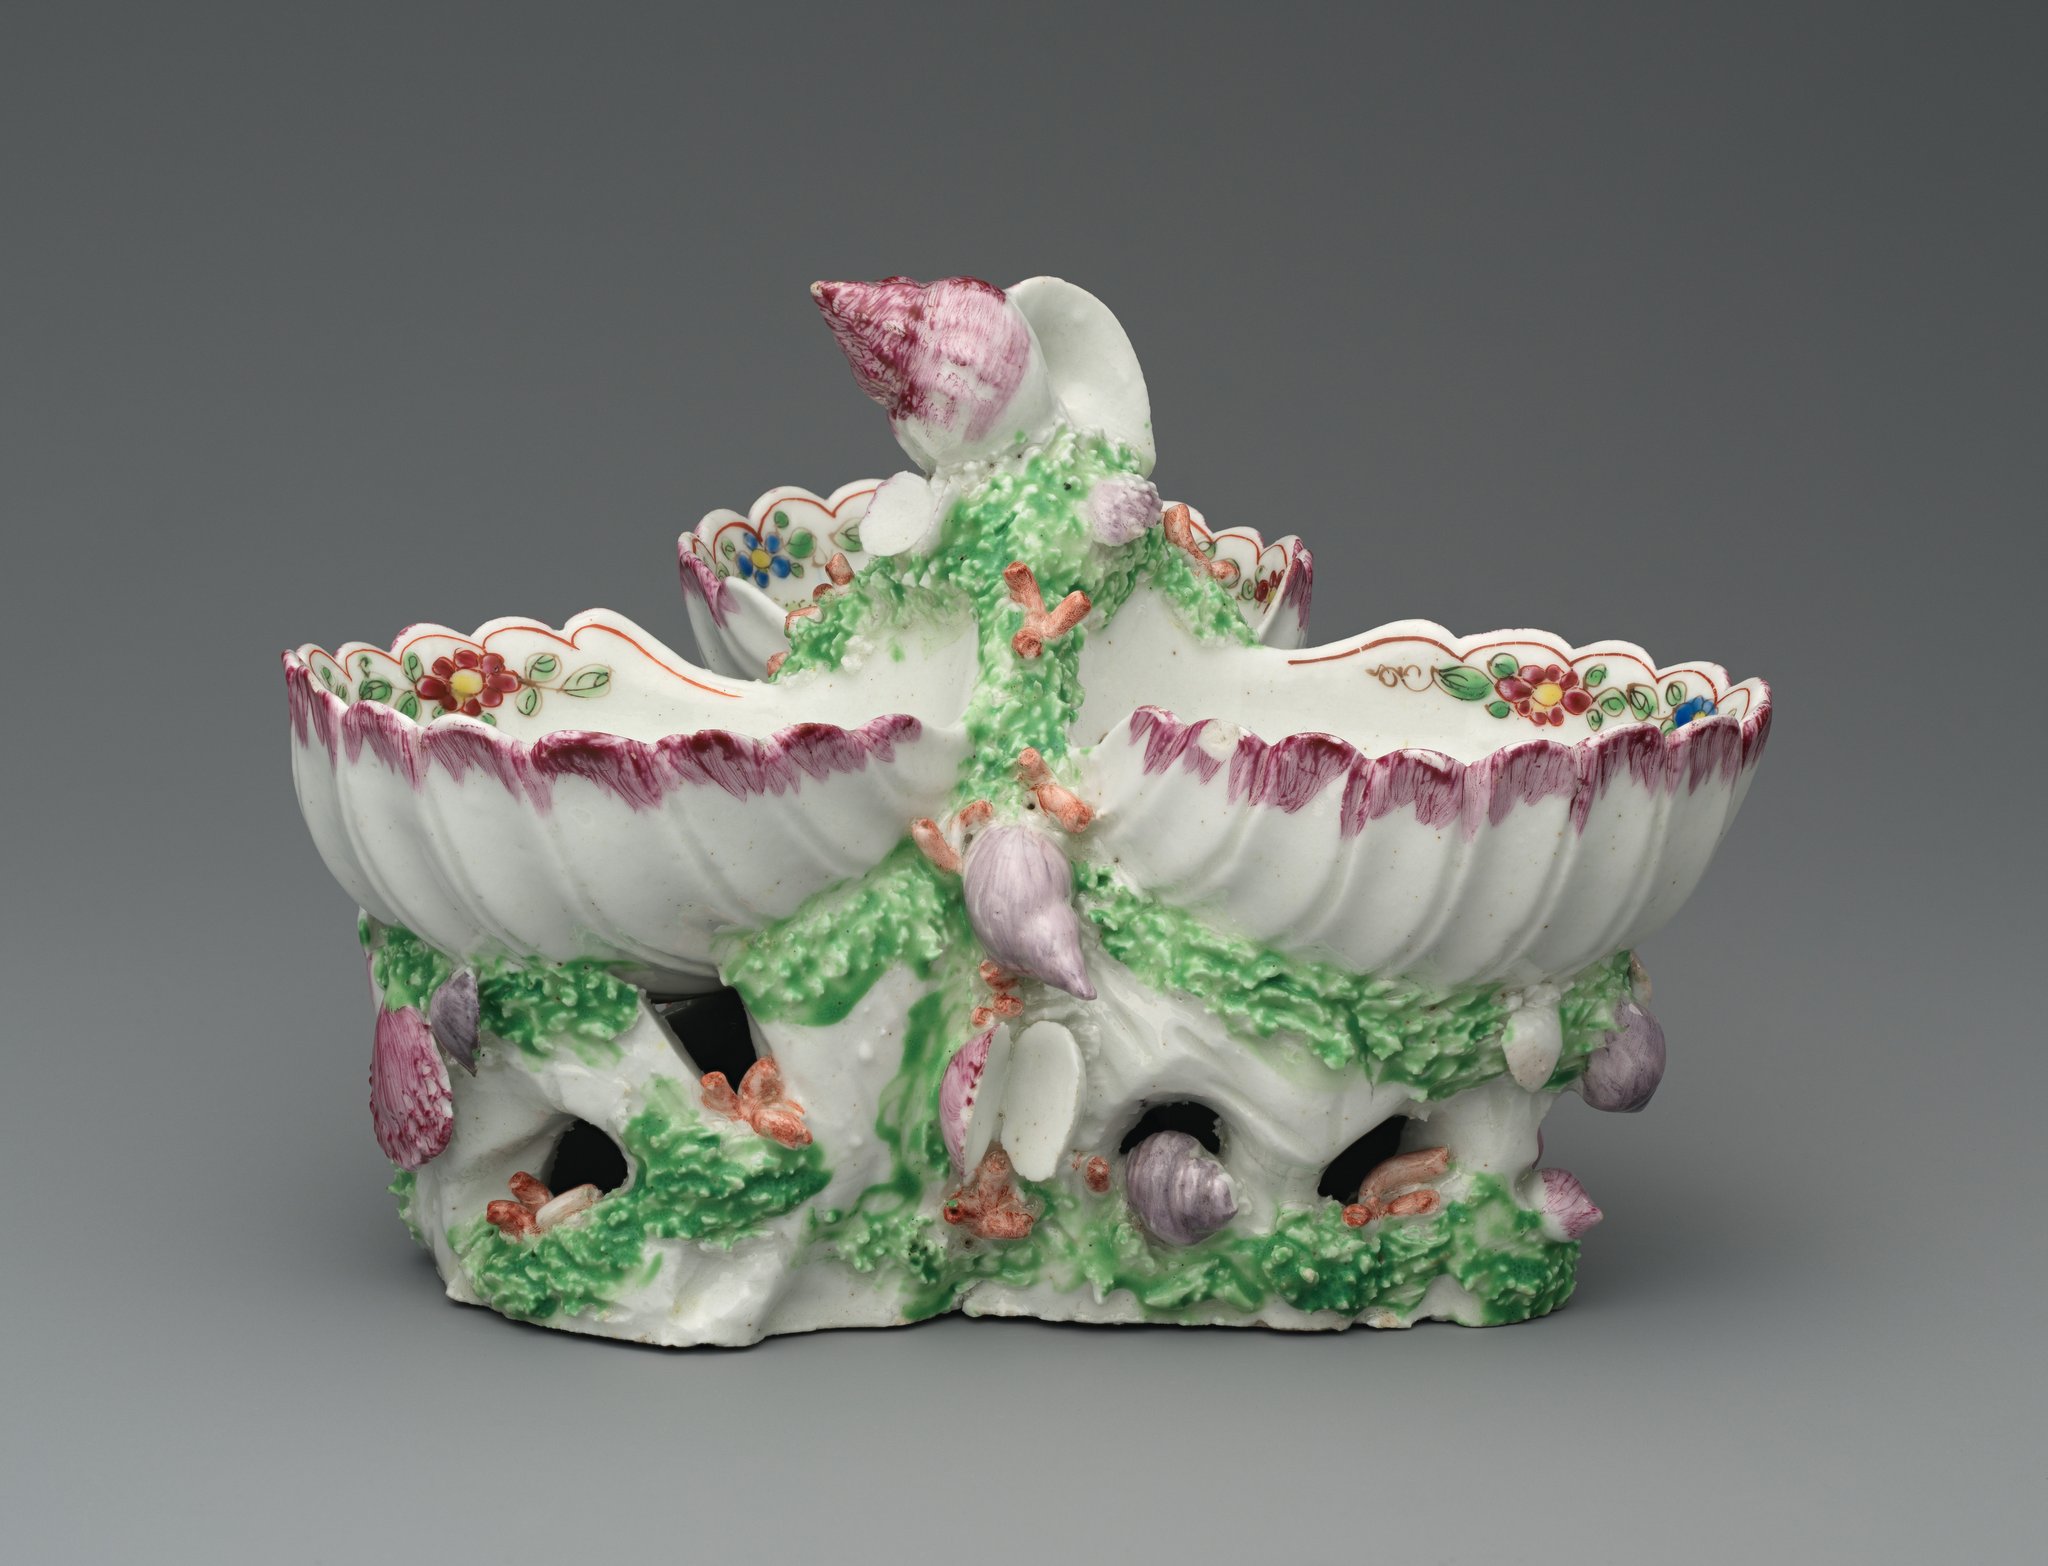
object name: sweetmeat dish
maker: bow porcelain factory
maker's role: factory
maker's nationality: british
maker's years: 1747-1776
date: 1750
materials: soft paste porcelain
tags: flowers,shells